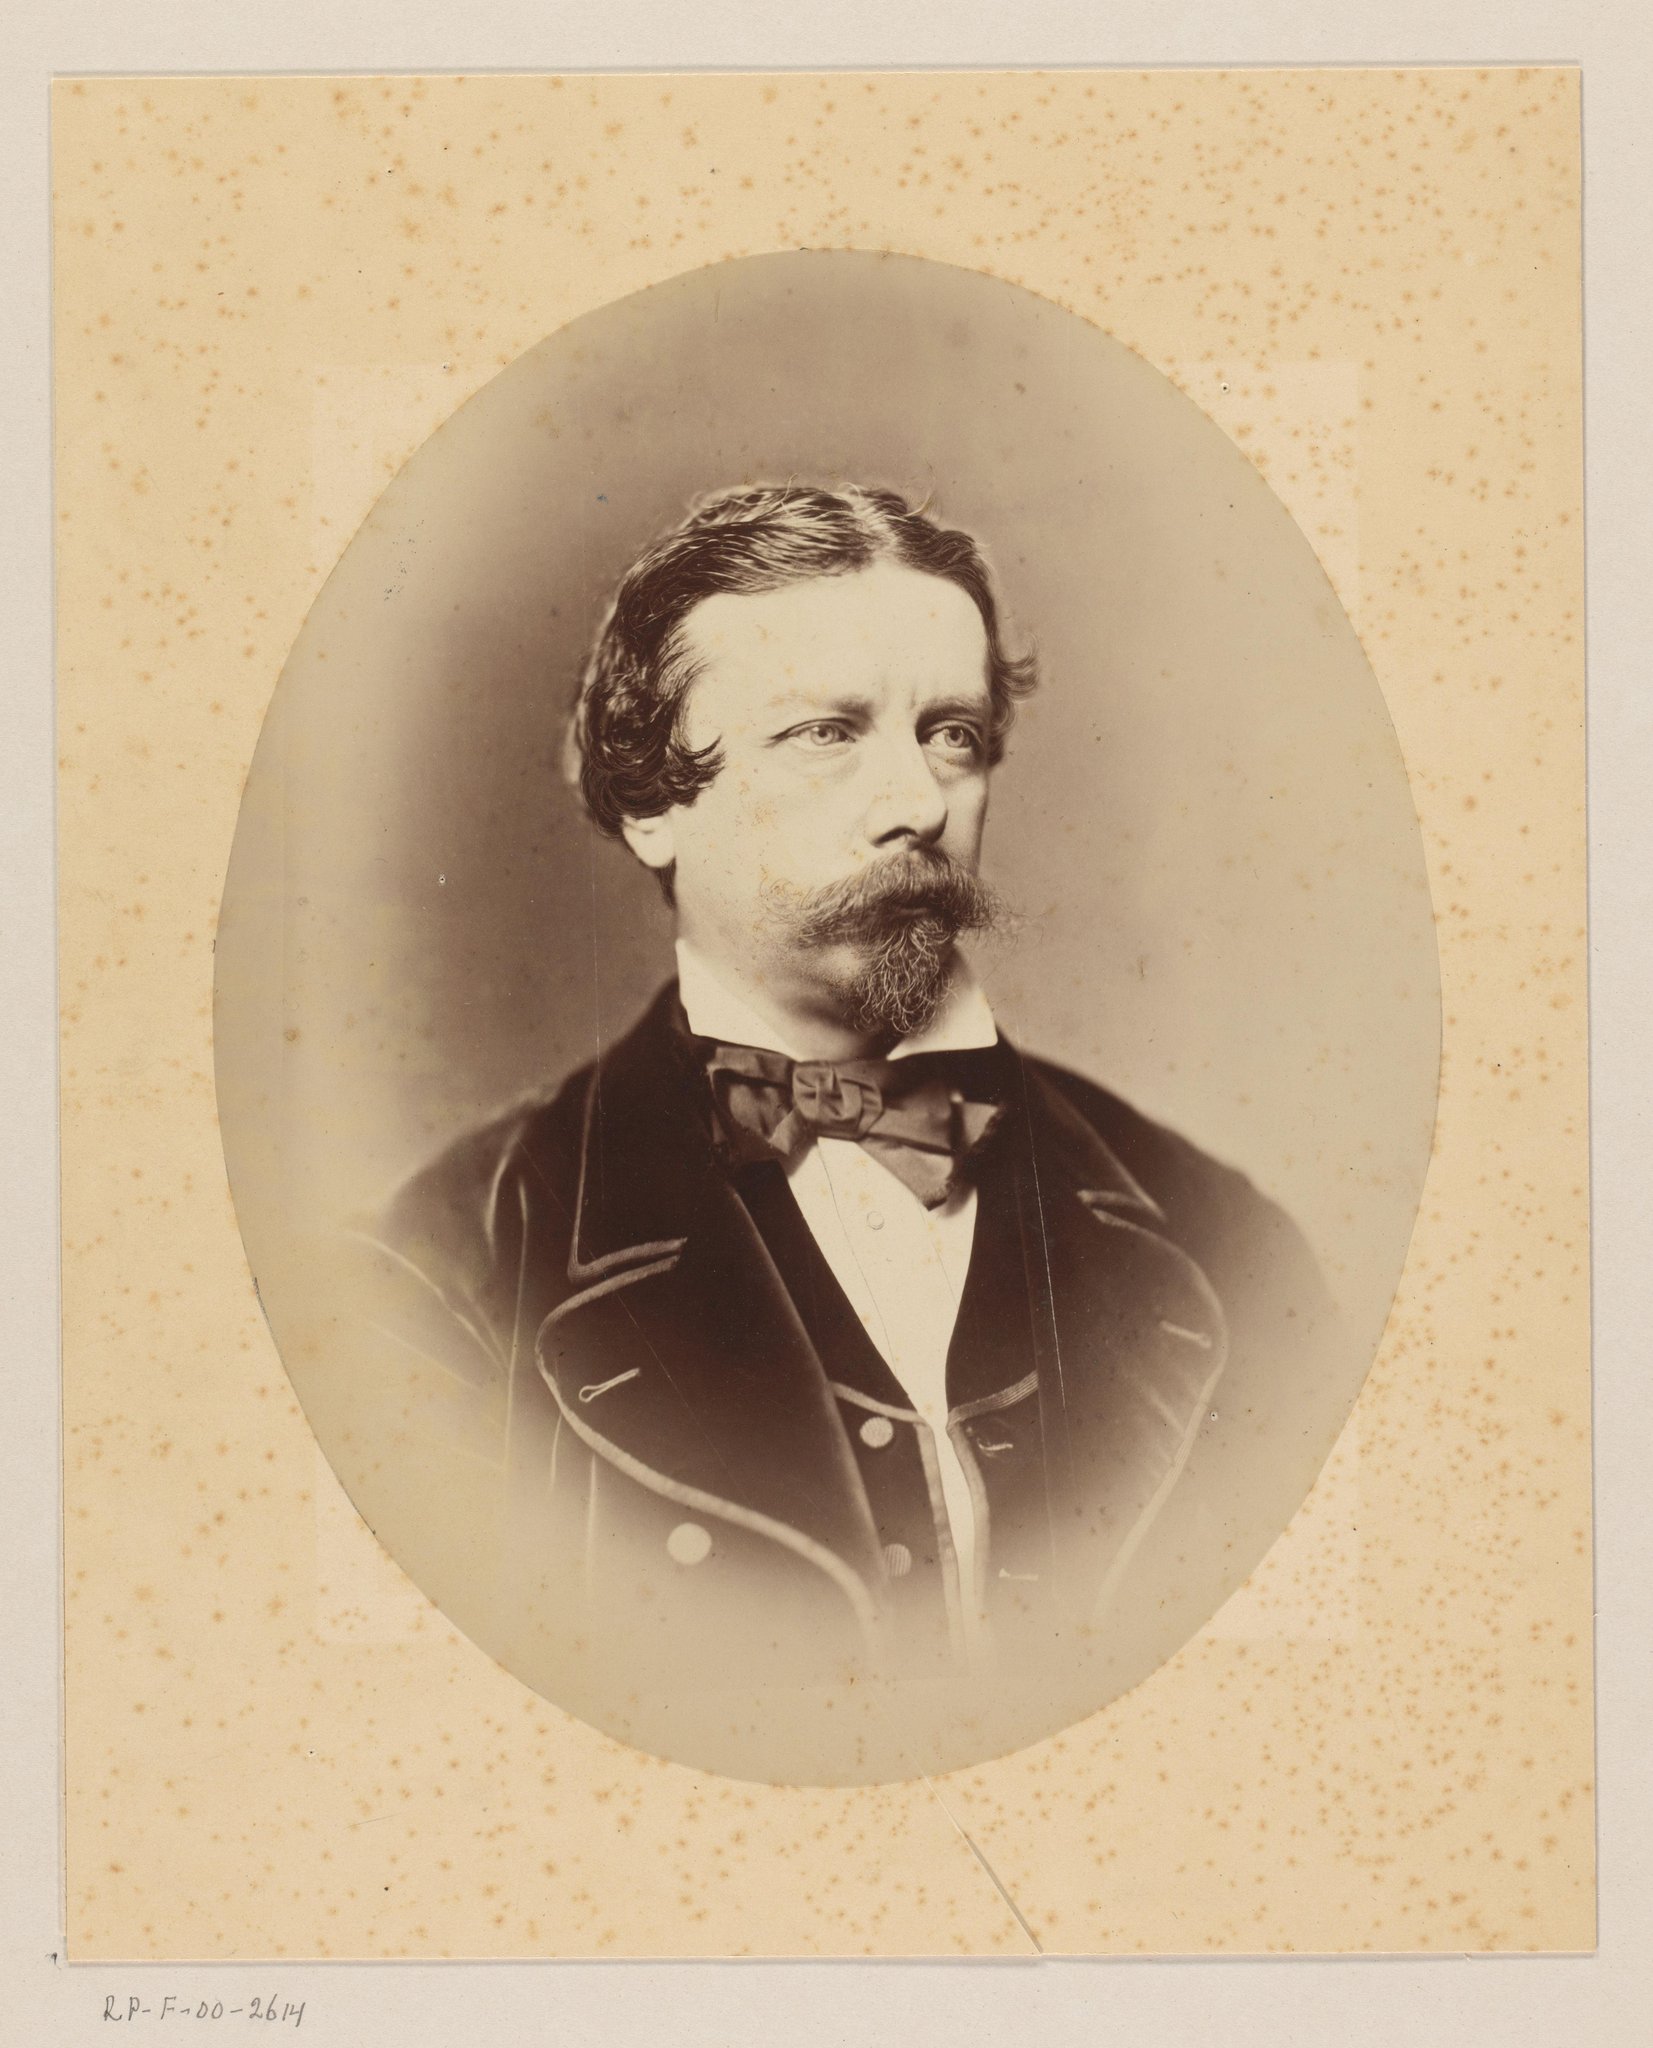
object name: photograph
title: Portret van Abraham Willet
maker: theodor brüggemann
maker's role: print maker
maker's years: 1822-1888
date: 1865-1880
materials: cardboard, paper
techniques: albumen print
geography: netherlands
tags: amsterdam, historical persons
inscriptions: collector's mark: Lugt 2228, inscription: ‘Portret van de Heer Abr Willet/ stichter van Museum Willet-Holthuysen/ te Amsterdam’